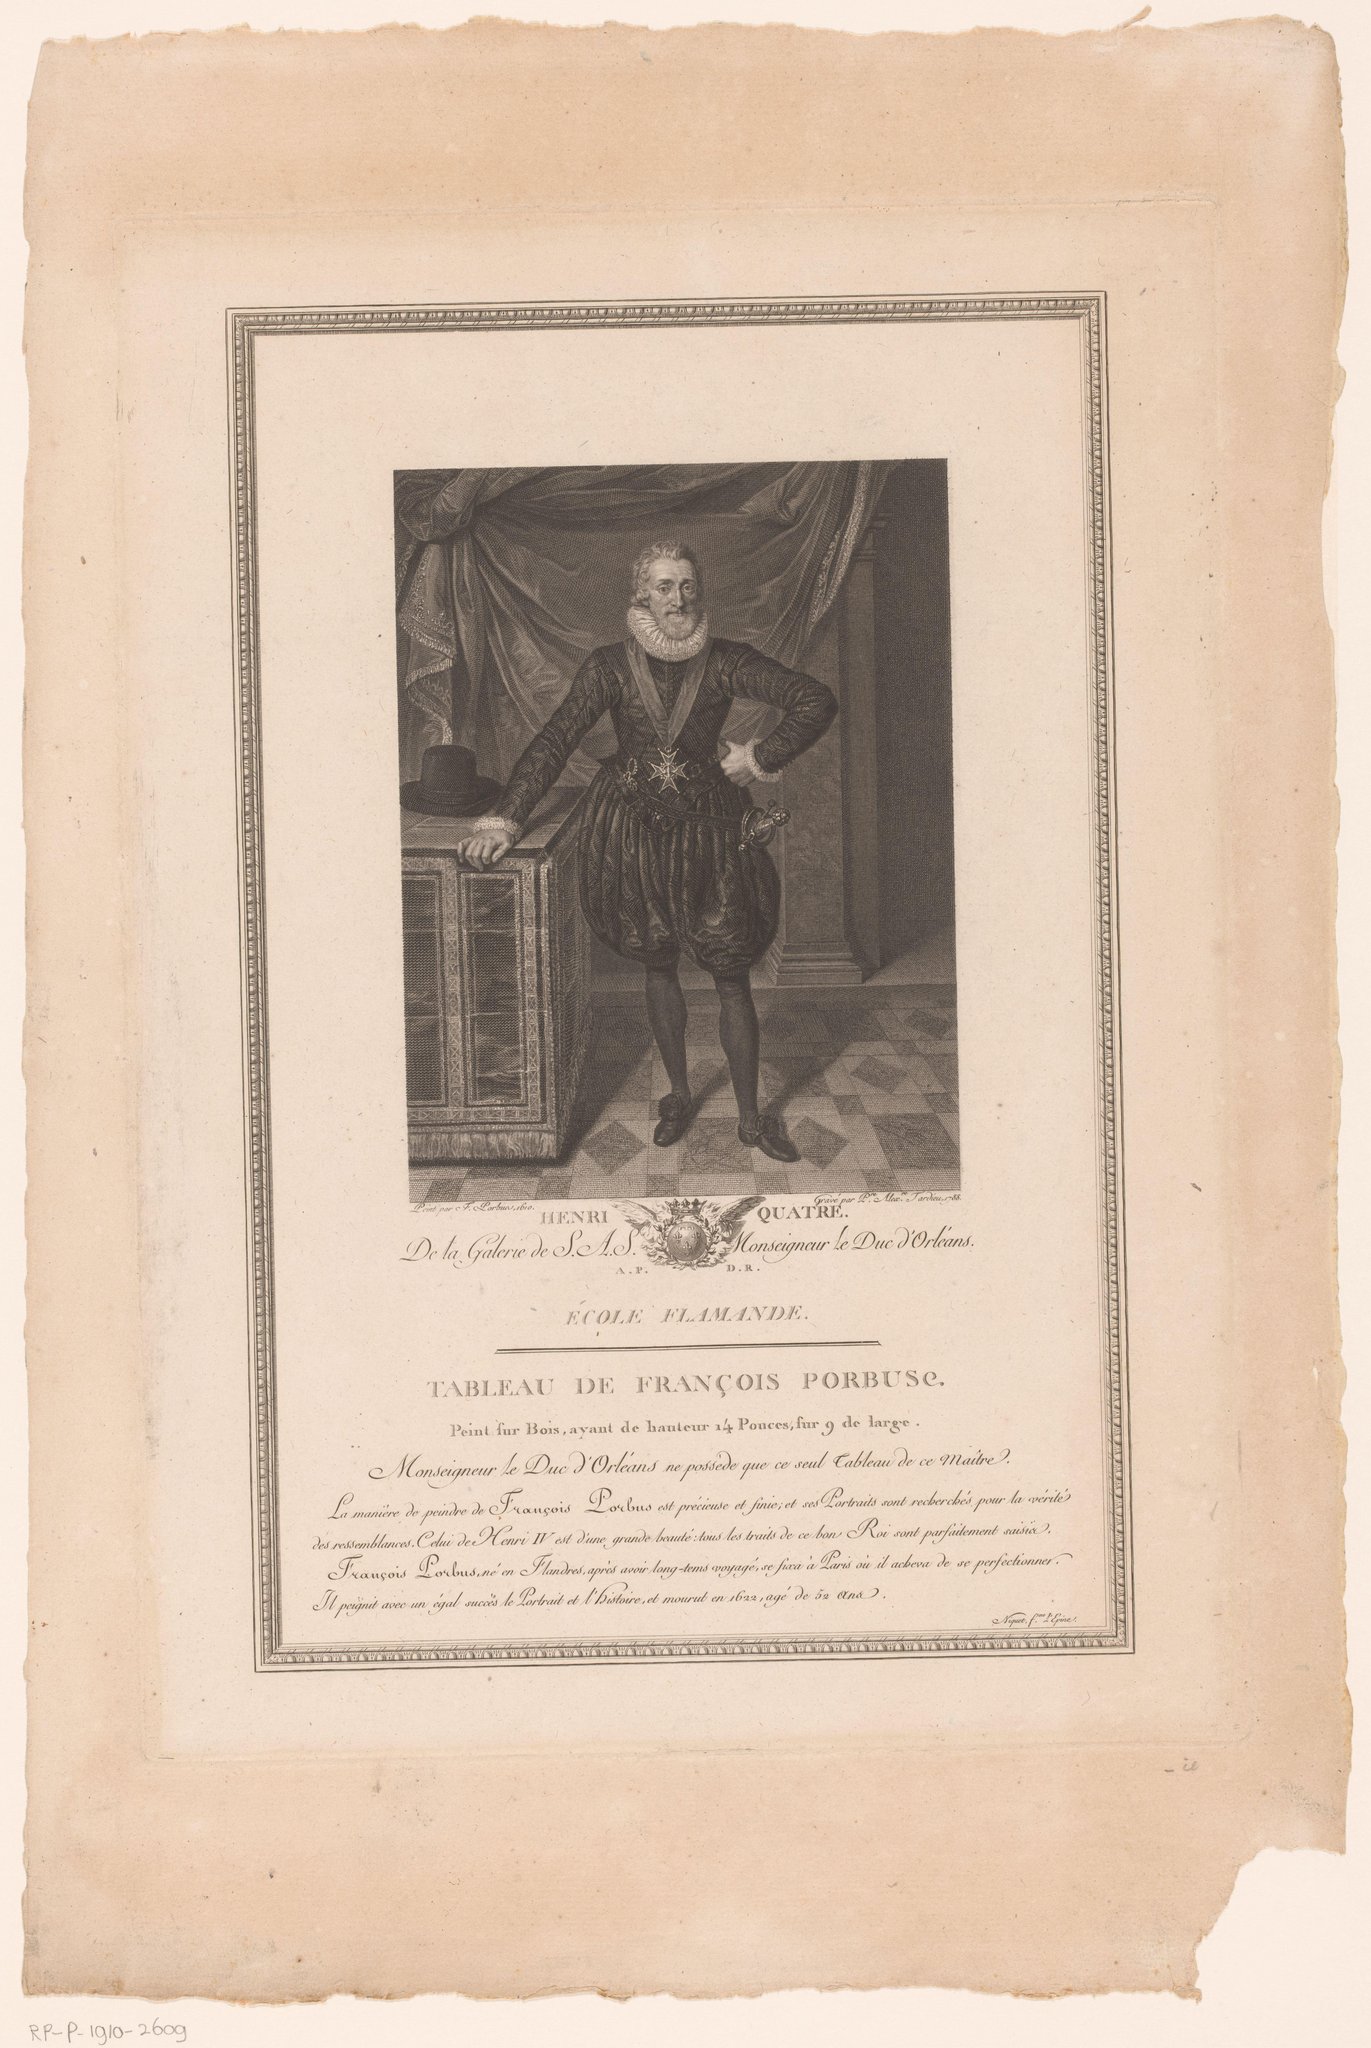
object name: print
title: La Galerie du Palais Royal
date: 1786-1808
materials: paper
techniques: engraving, etching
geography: paris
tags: hendrik iv (koning van frankrijk en navarra), historical persons, historical persons (portraits and scenes from the life) (+ full length portrait), king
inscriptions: collector's mark: Lugt 2228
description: Onderdeel van een serie van 354 prenten naar schilderijen uit de collectie van de Hertog van Orléans, getiteld: La Galerie du Palais Royal, uitgebracht tussen 1786 en 1808. De serie werd uitgegeven door Jacques Couché die het project samen met Jacques Bouillard leidde.